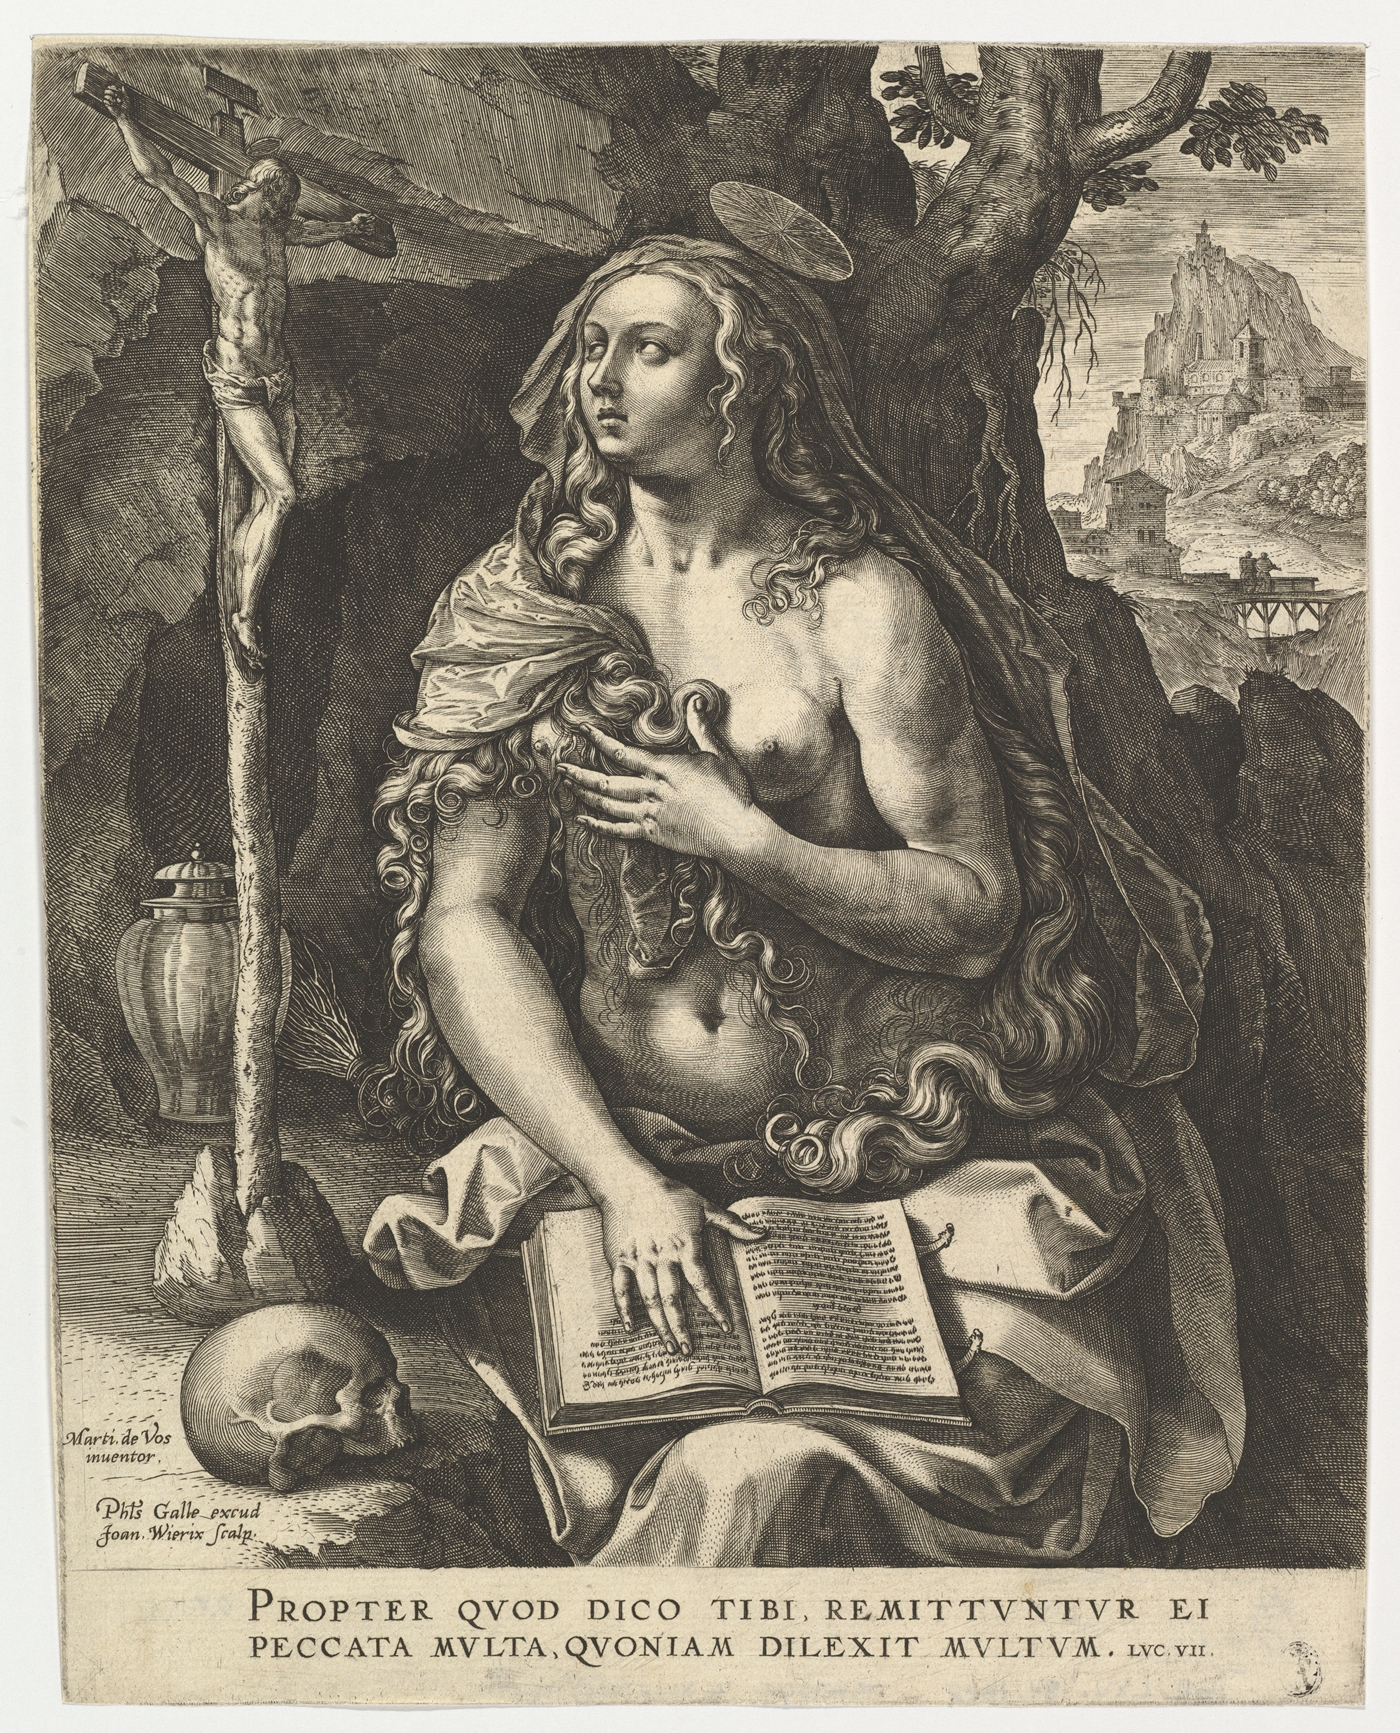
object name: print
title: Mary Magdalen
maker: maerten de vos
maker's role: artist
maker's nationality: netherlandish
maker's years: 1532-1603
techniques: engraving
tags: christ,mary magdalene,crucifixion